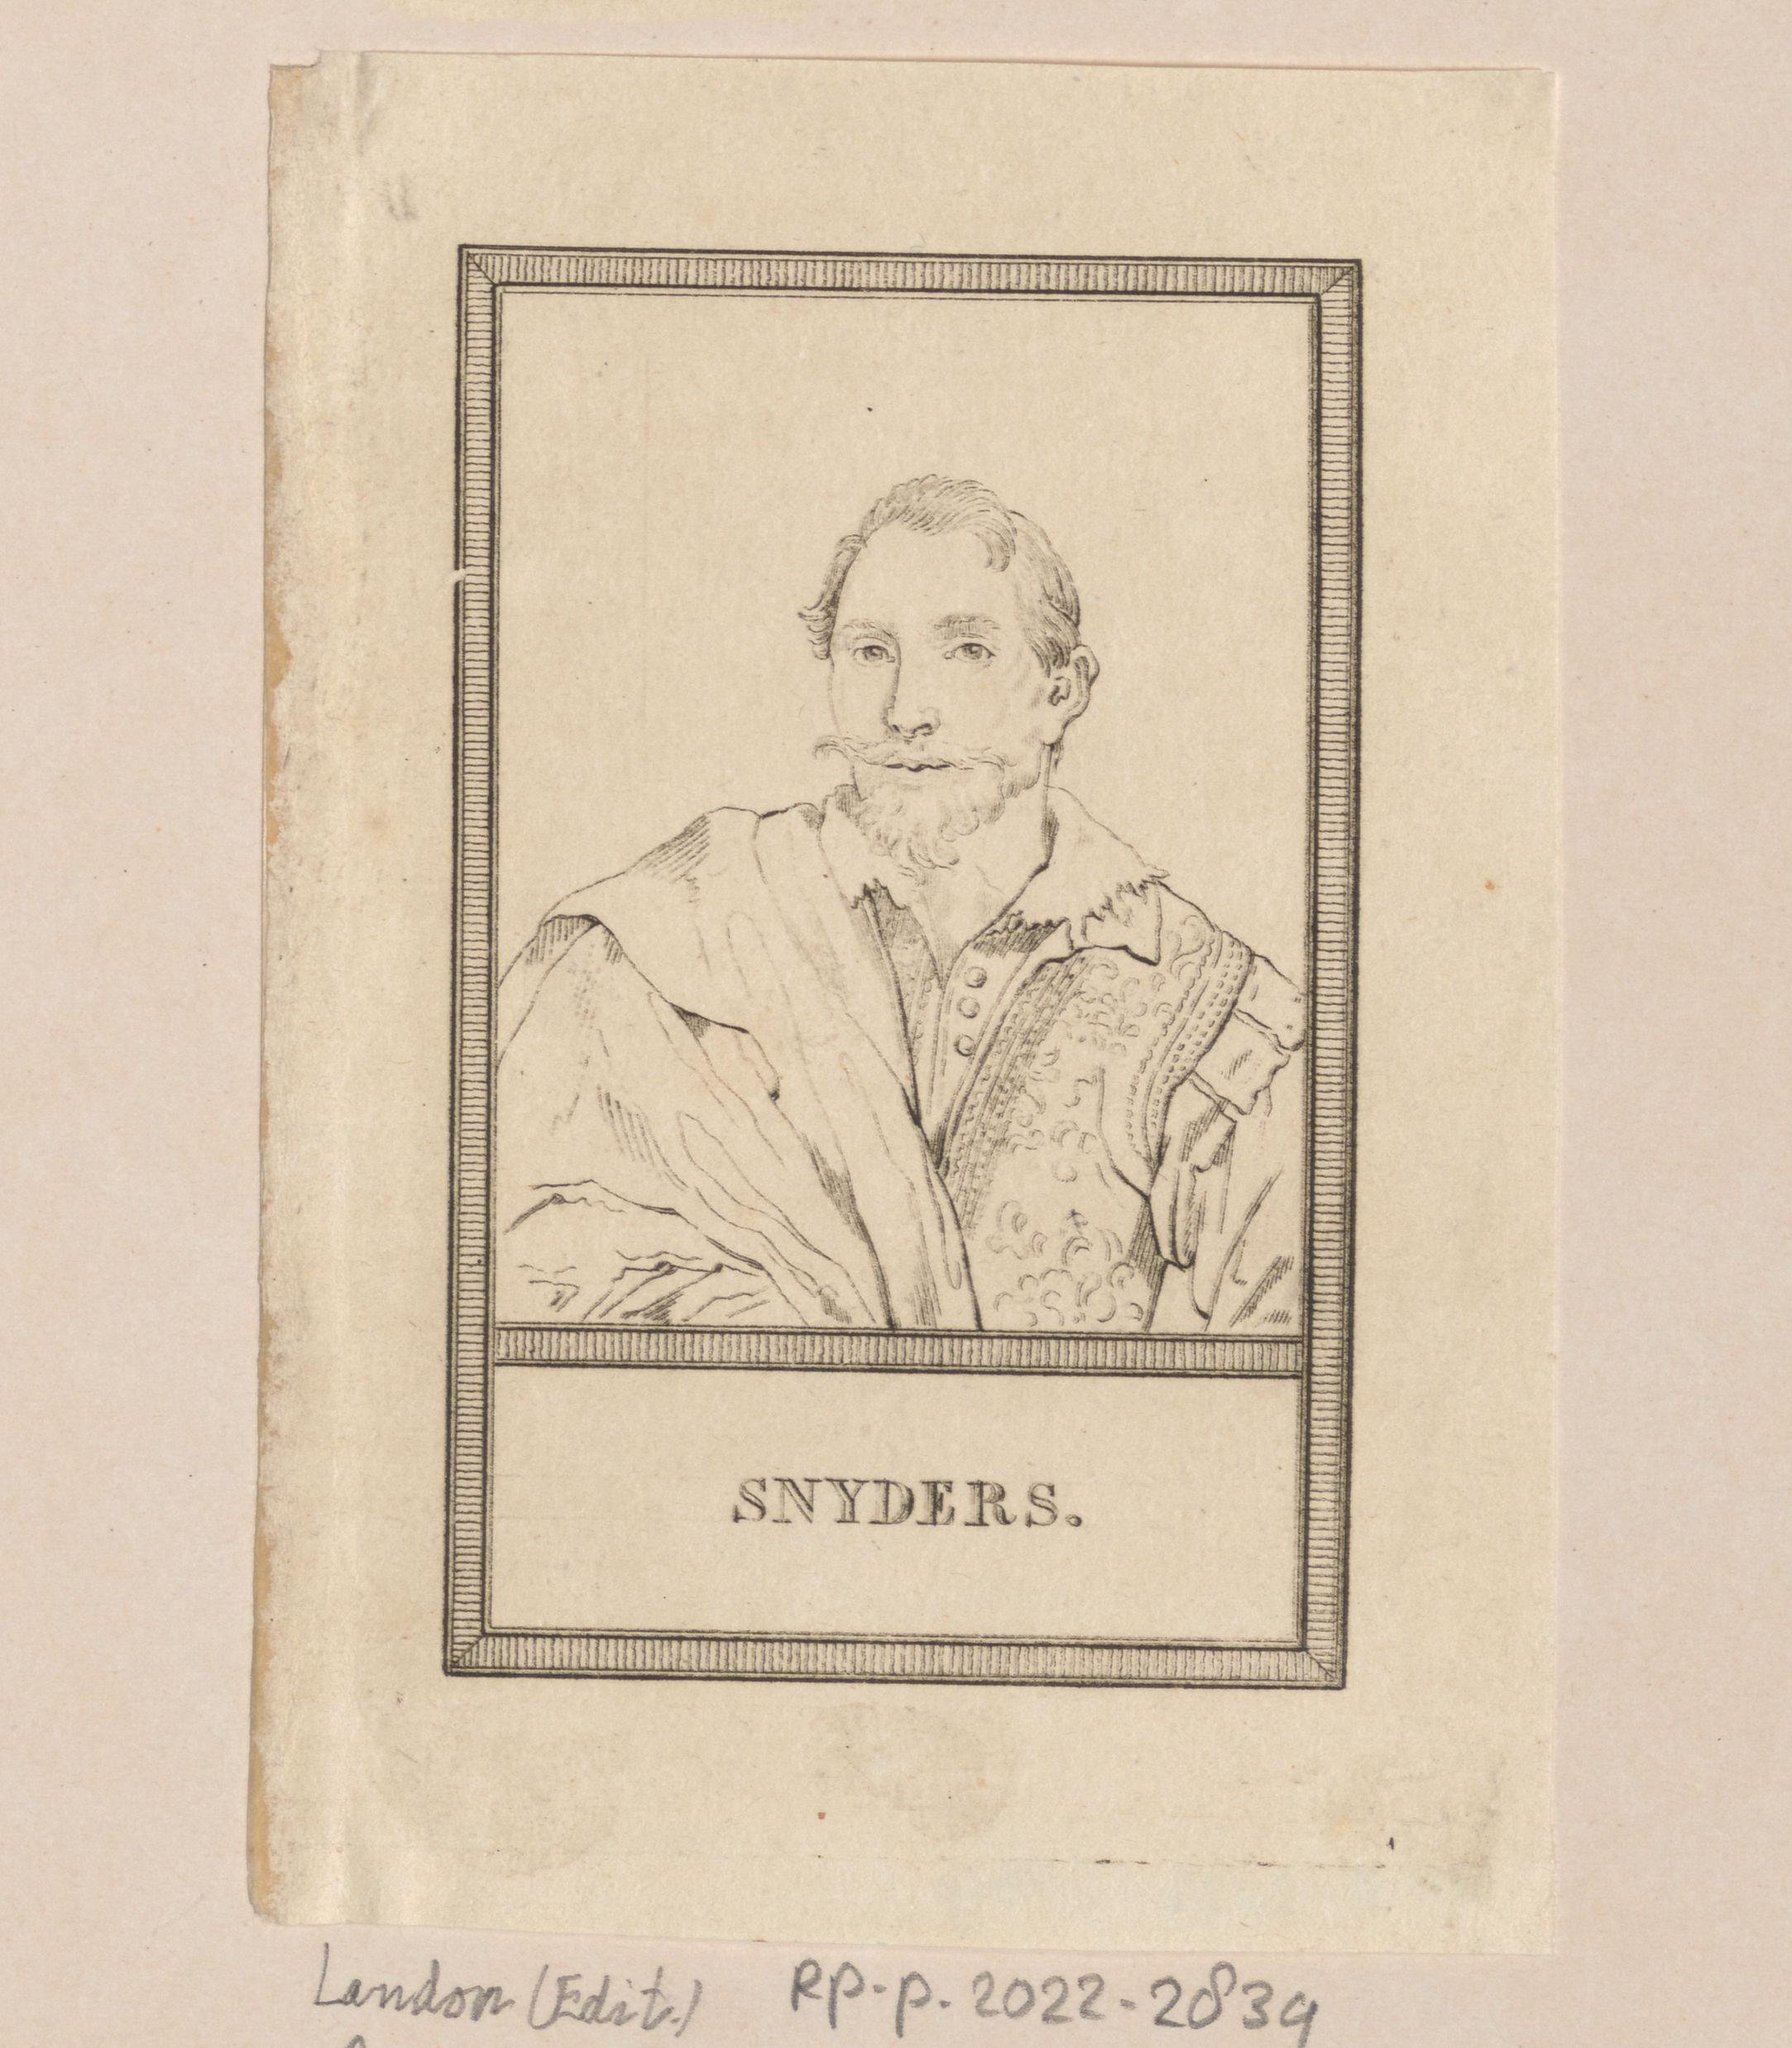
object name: print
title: Portret van Frans Snijders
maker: Anonymous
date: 1805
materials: paper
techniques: etching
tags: painter, draughtsman, frans snijders, historical persons, portrait, self-portrait of artist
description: Prent waarschijnlijk uit: Landon, Charles Paul. Galerie historique des hommes les plus célèbres (...). Parijs: Imprimerie des Annales du Musée, 1805, dl. 5.